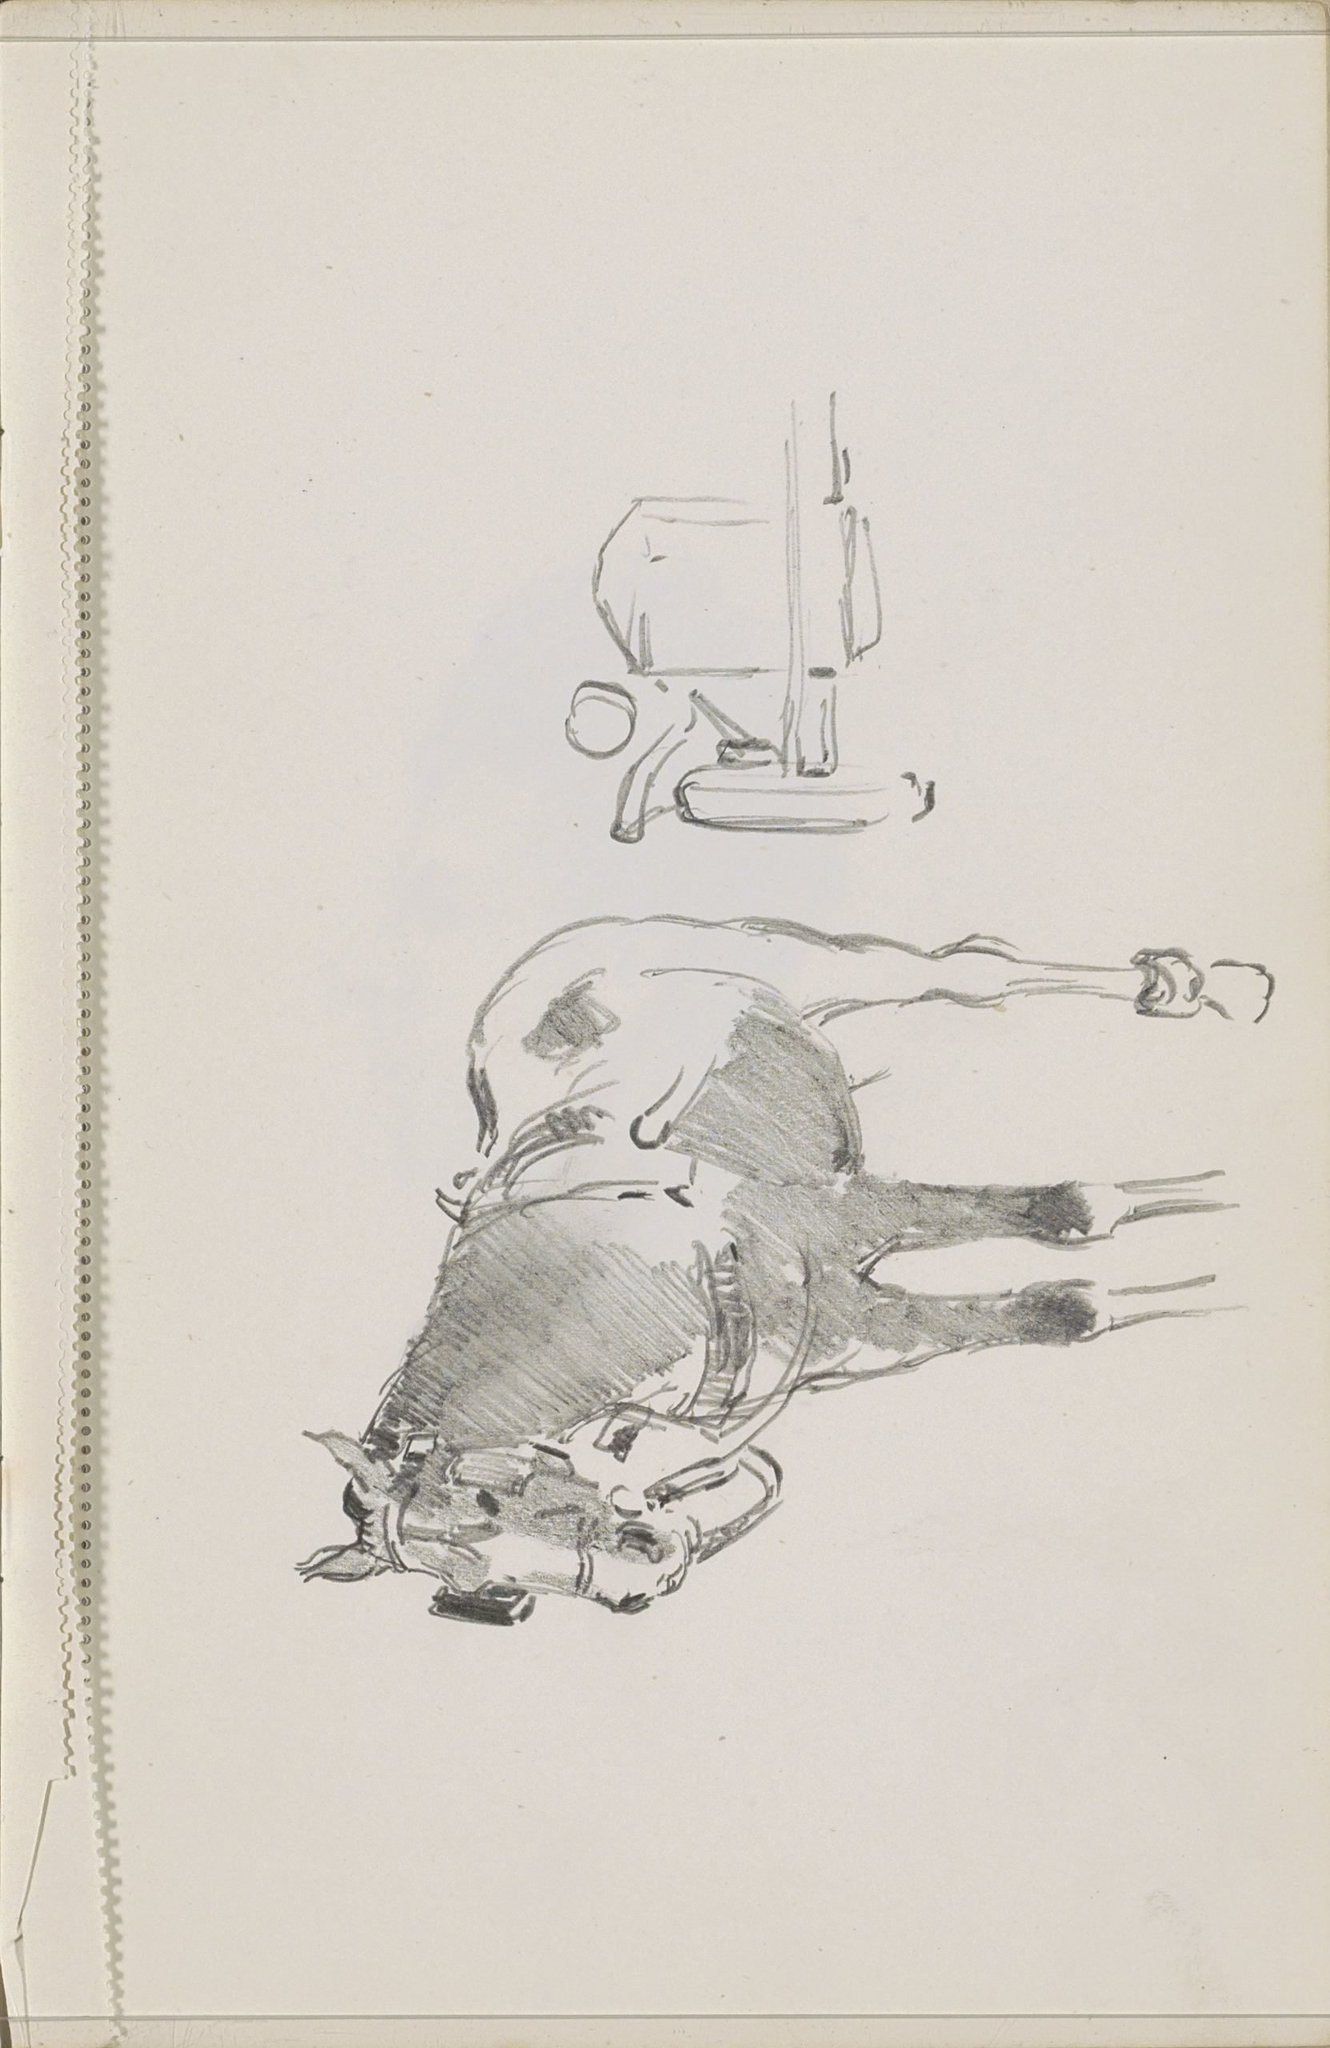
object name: sketchbook leaf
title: Paard en wagen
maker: cornelis vreedenburgh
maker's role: draughtsman, print maker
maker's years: 1880-1946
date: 1890-1946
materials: paper, pencil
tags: animal traction, animal-drawn vehicle (carriage etc.)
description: Blad 7 recto uit een schetsboek met 53 bladen.